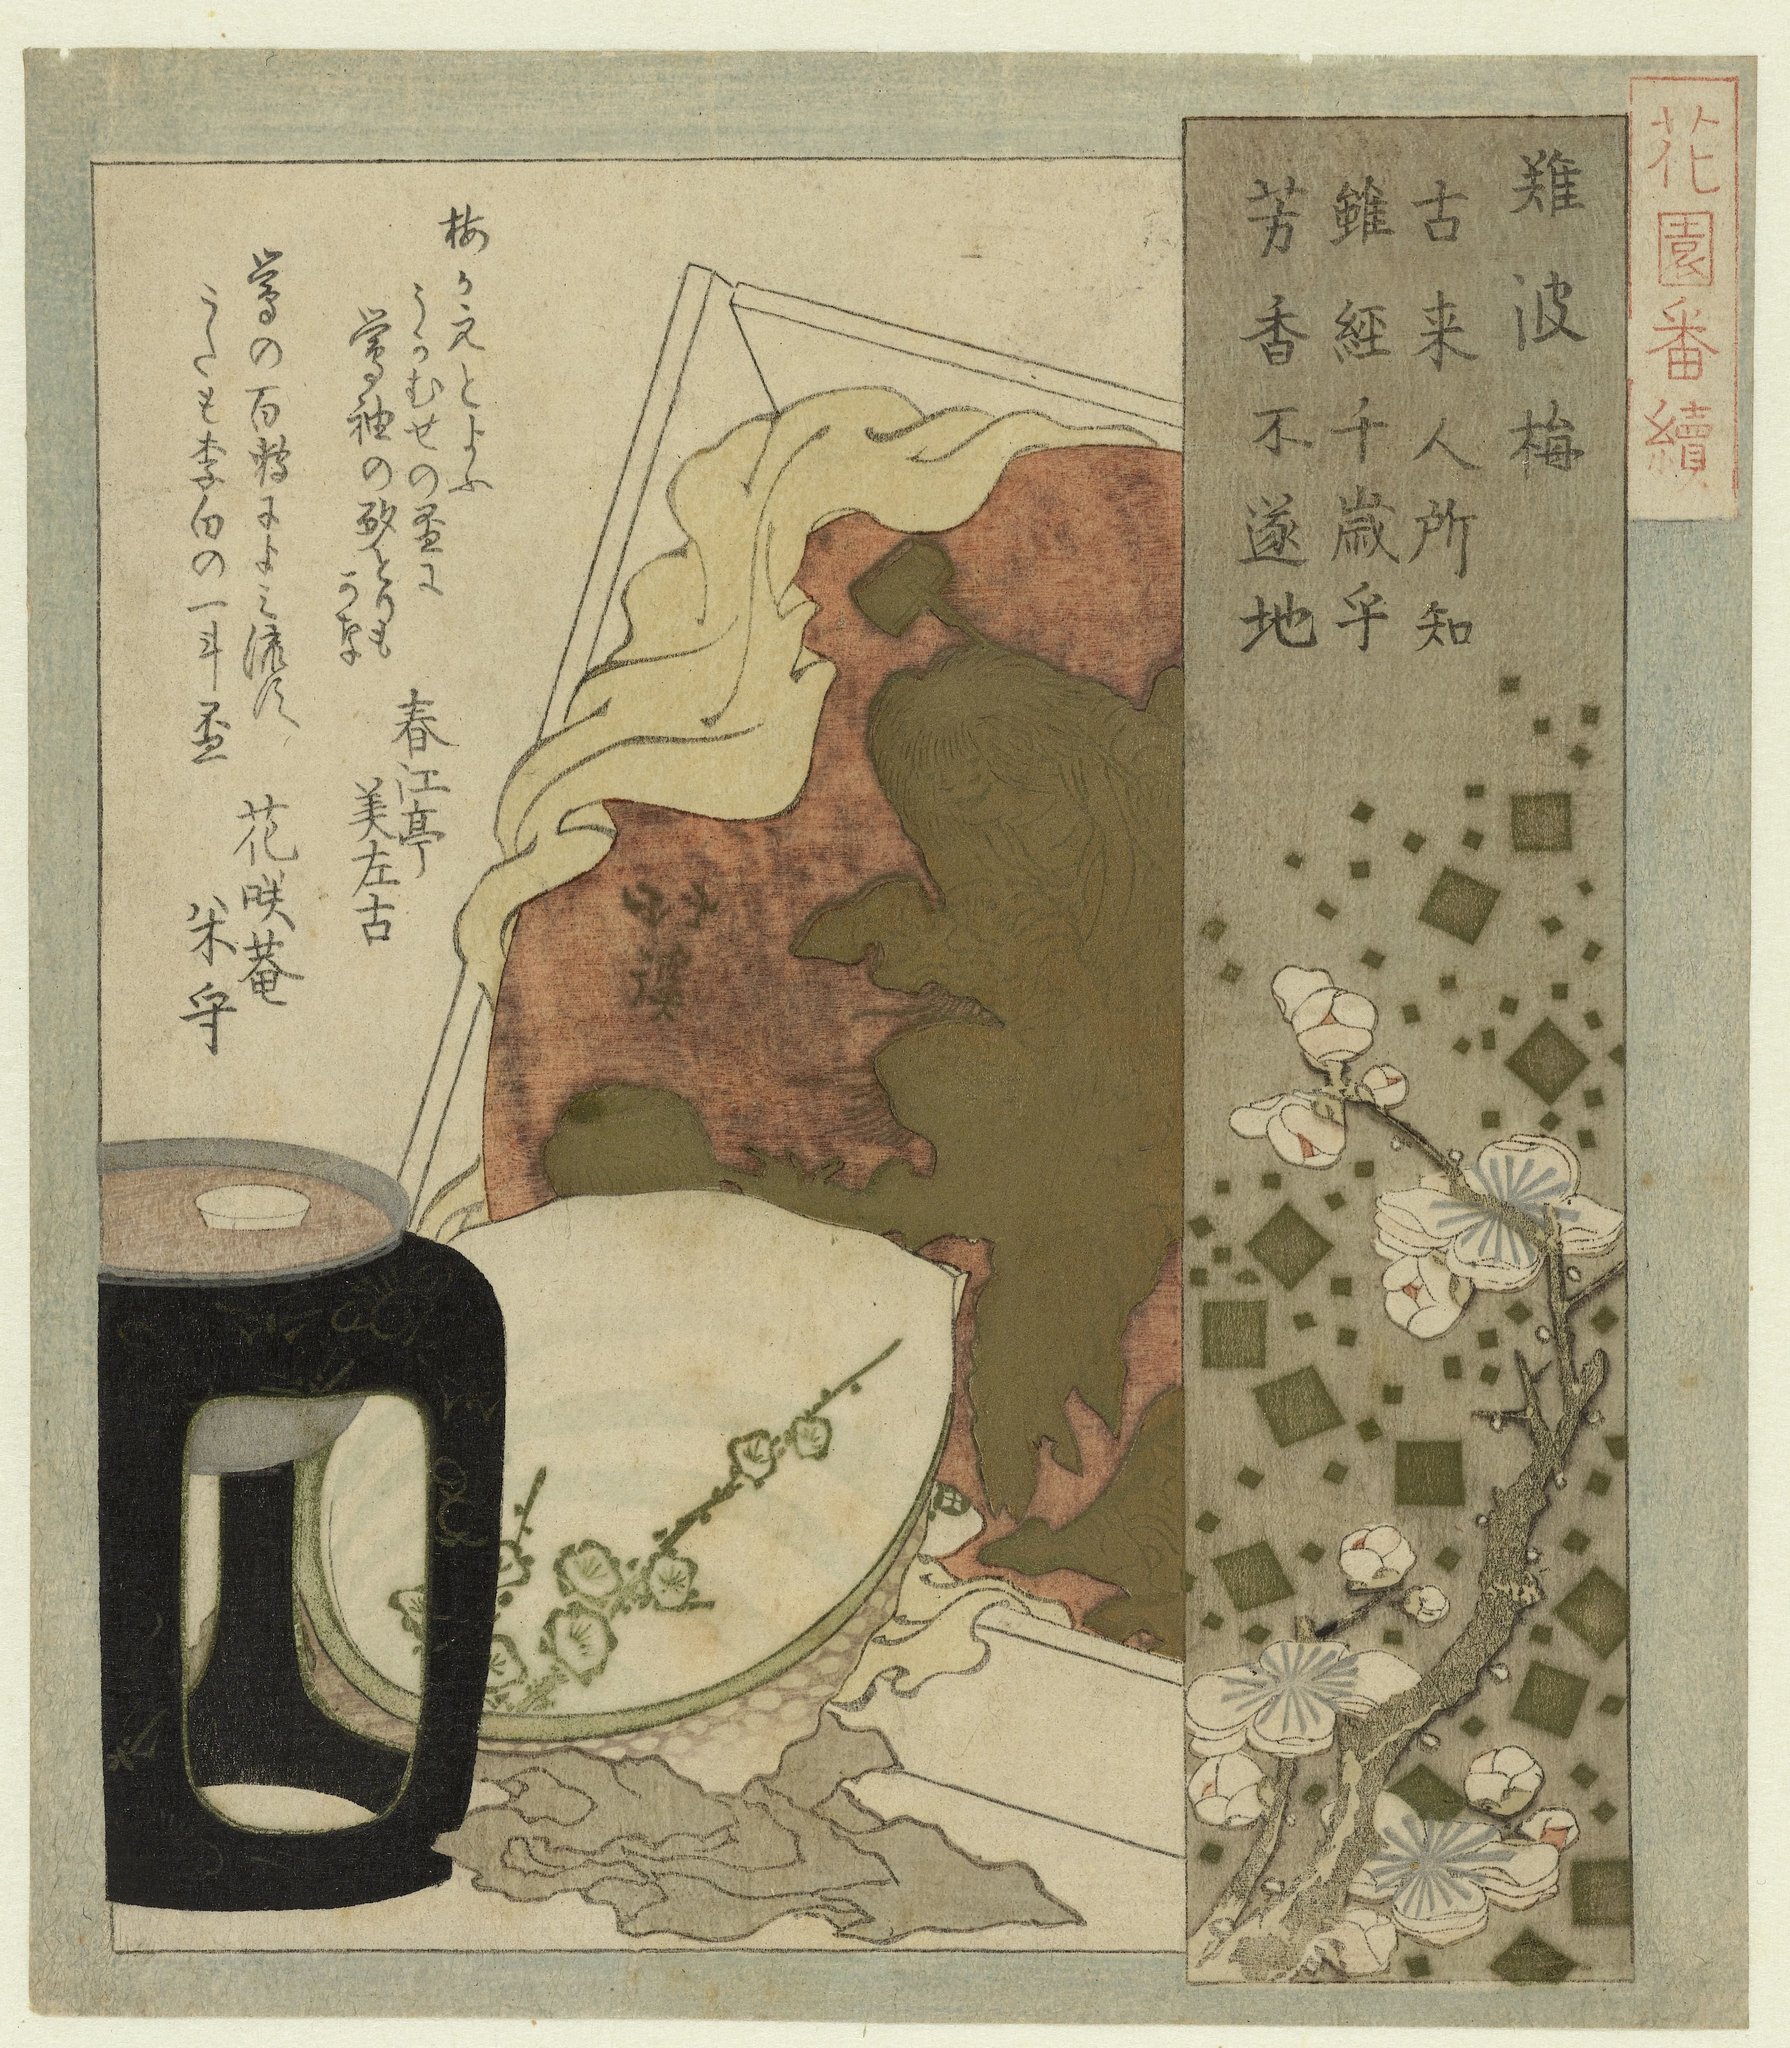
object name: surimono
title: Een serie voor de Hanazono dichtersvereniging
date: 1823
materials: paper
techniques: blind stamped, woodcut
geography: japan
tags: plants; vegetation (+ flowers, blossom, blossoming)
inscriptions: collector's mark, passe-partout, bottom left, printed: JABdH with a rooster., collector's mark, verso, stamped: Lugt 2228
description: Een stilleven van verschillende sake (rijstwijn) kopjes. Links een klein kopje van dun porselein, drijvend in water in een zilveren kom die in een houder van zwart lakwerk staat. Ernaast een kopje gemaakt van een witte schelp, binnenin gedecoreerd met pruimenbloesem. Rechts een groot, deels in doek gewikkeld, sake kopje van rood lakwerk, versierd met de afbeelding van een shôjô, een mythologisch wezen dat aan de kust zou leven en zijn dagen sake drinkend doorbrengt. Rechts pruimenbloesem onder een gedicht. Naniwa is de traditionele naam van de stad Osaka, bekend om de pruimenbloesems en sake. Met twee gedichten.